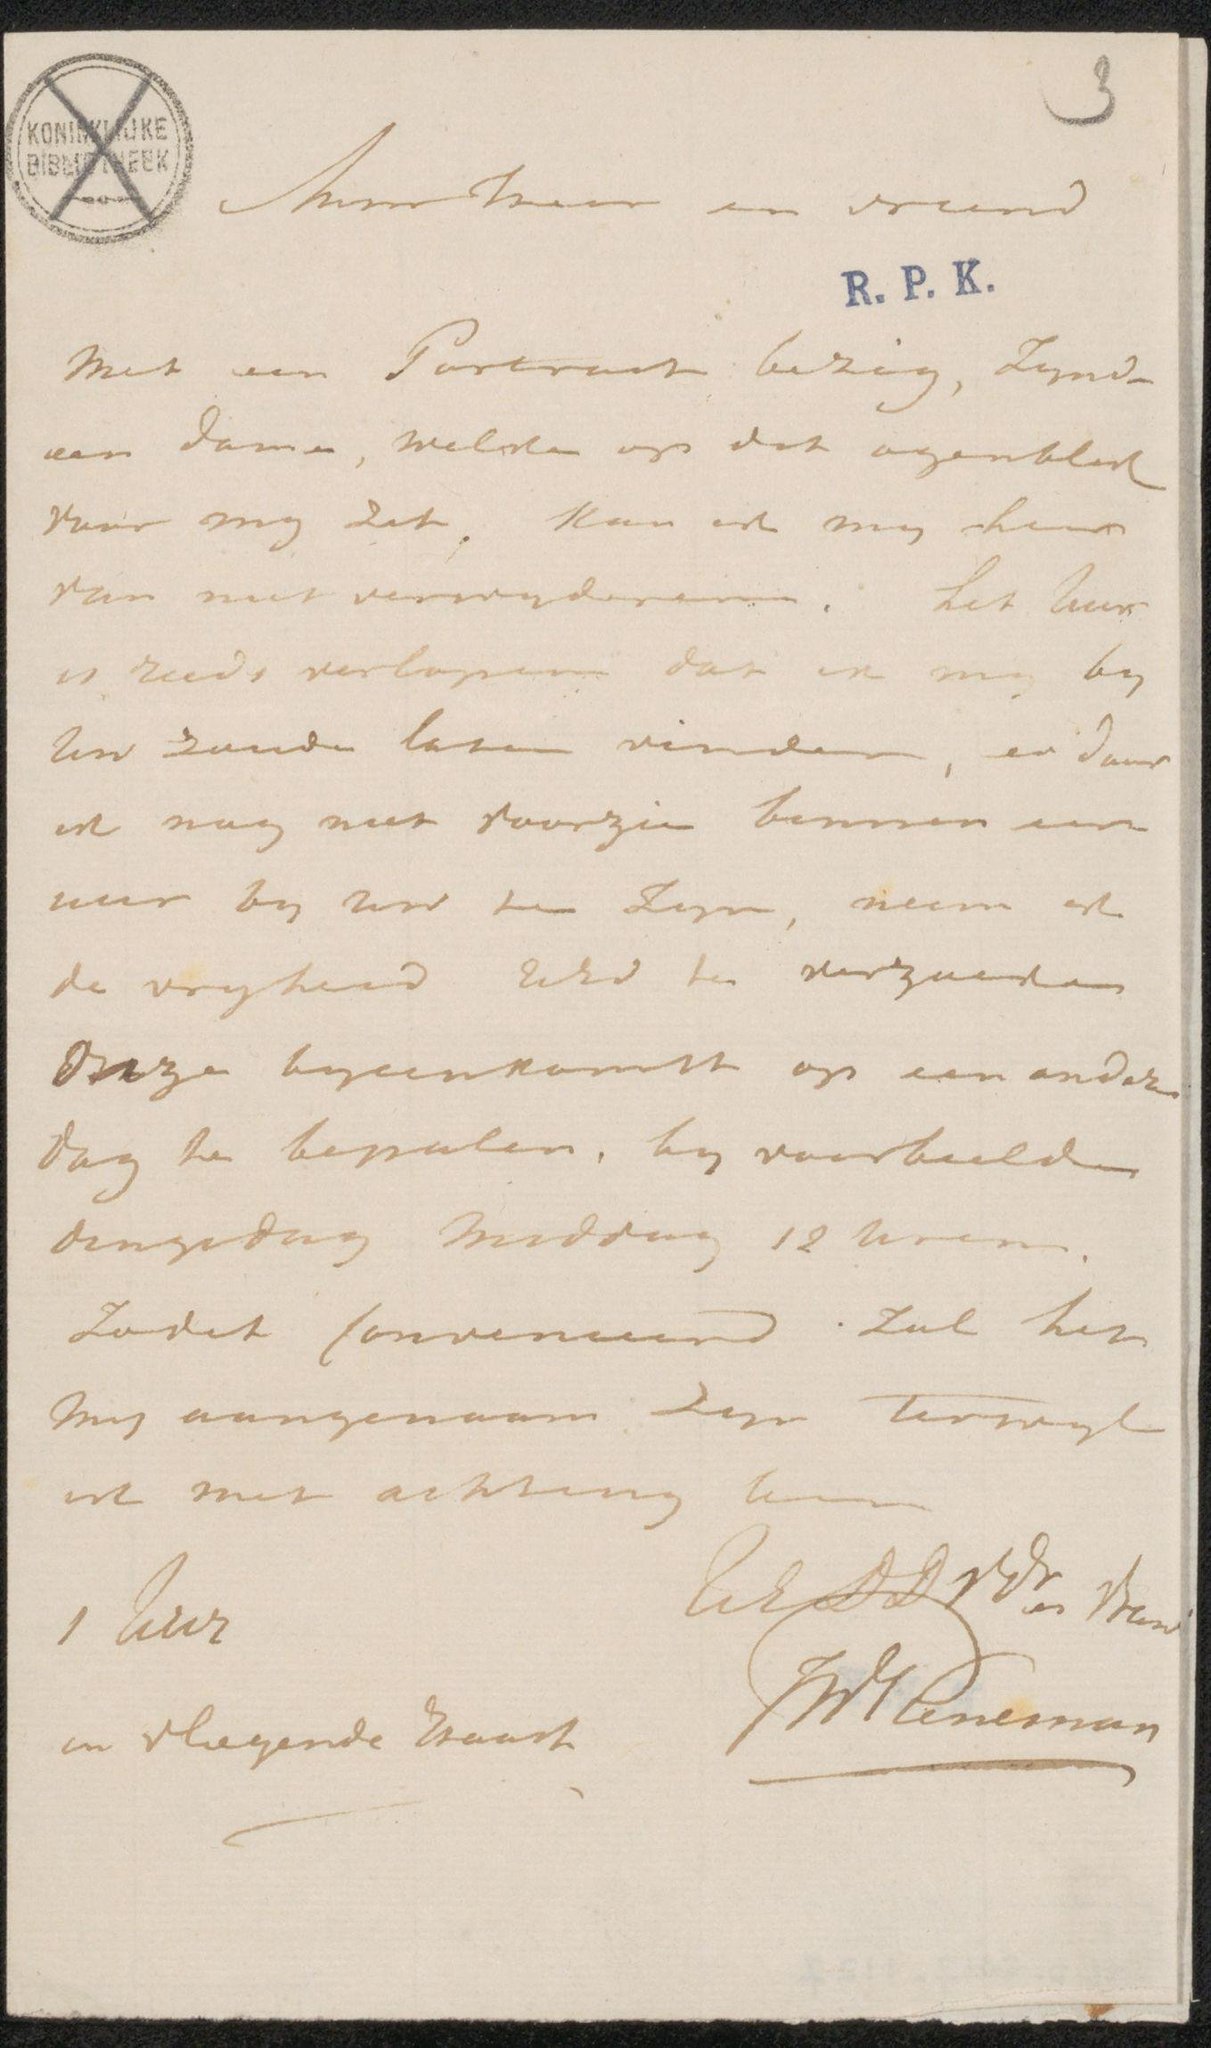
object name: letter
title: Brief aan Ernst Willem Jan Bagelaar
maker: jan willem pieneman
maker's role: draughtsman, painter, print maker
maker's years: 1779-1853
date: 1820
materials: ink, paper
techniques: pen, writing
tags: ernst willem jan bagelaar, historical persons (portraits and scenes from the life)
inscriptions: collector's mark: ‘KONINKLIJKE BIBLIOTHEEK’, watermark, collector's mark: Lugt 2233